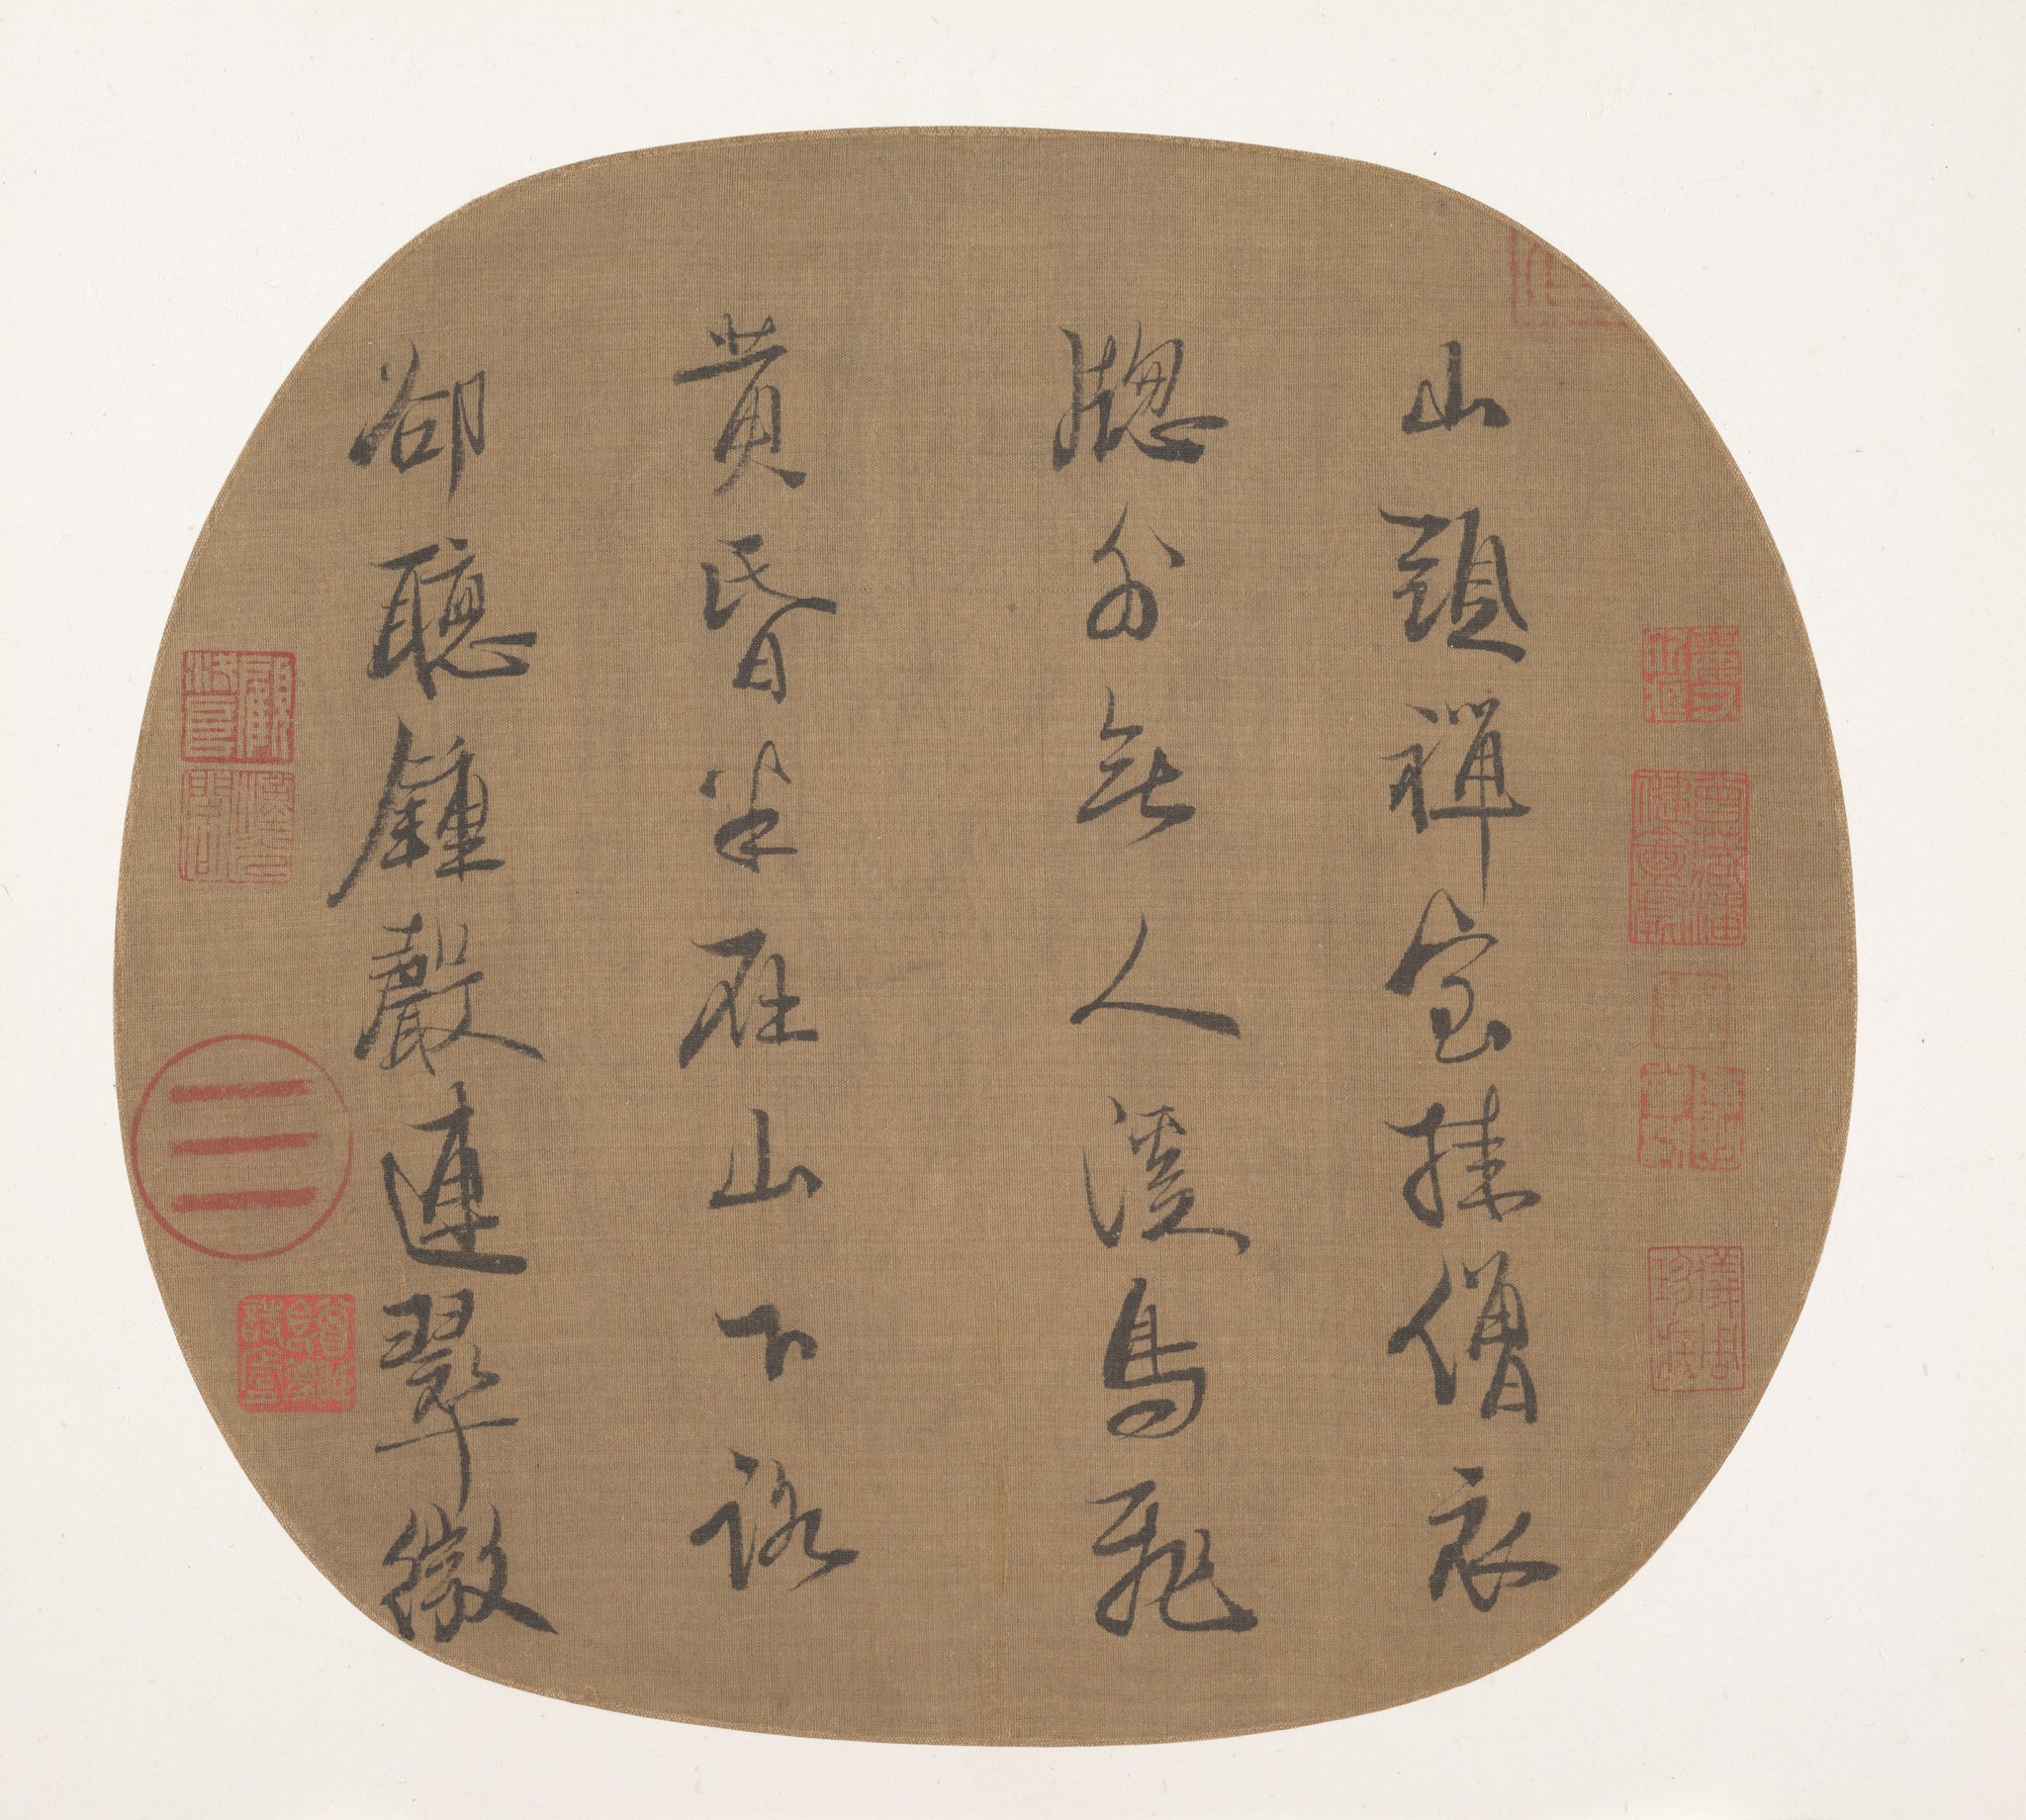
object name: fan mounted a an album leaf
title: Quatrain by Meng Haoran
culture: chinese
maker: emperor lizong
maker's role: artist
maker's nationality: chinese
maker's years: 1205-1264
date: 1260-1264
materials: ink, silk